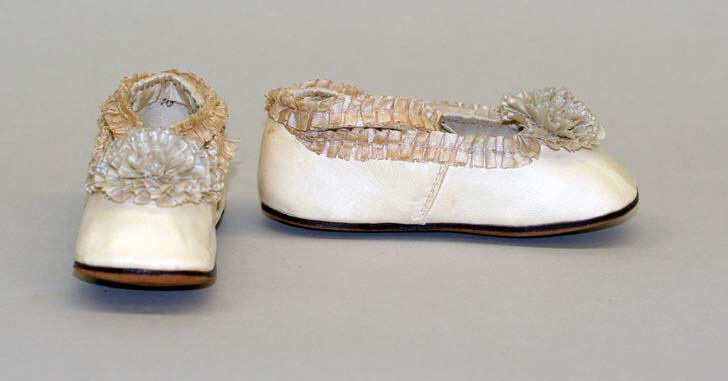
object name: shoe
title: Shoes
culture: french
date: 1876-1877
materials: leather, silk